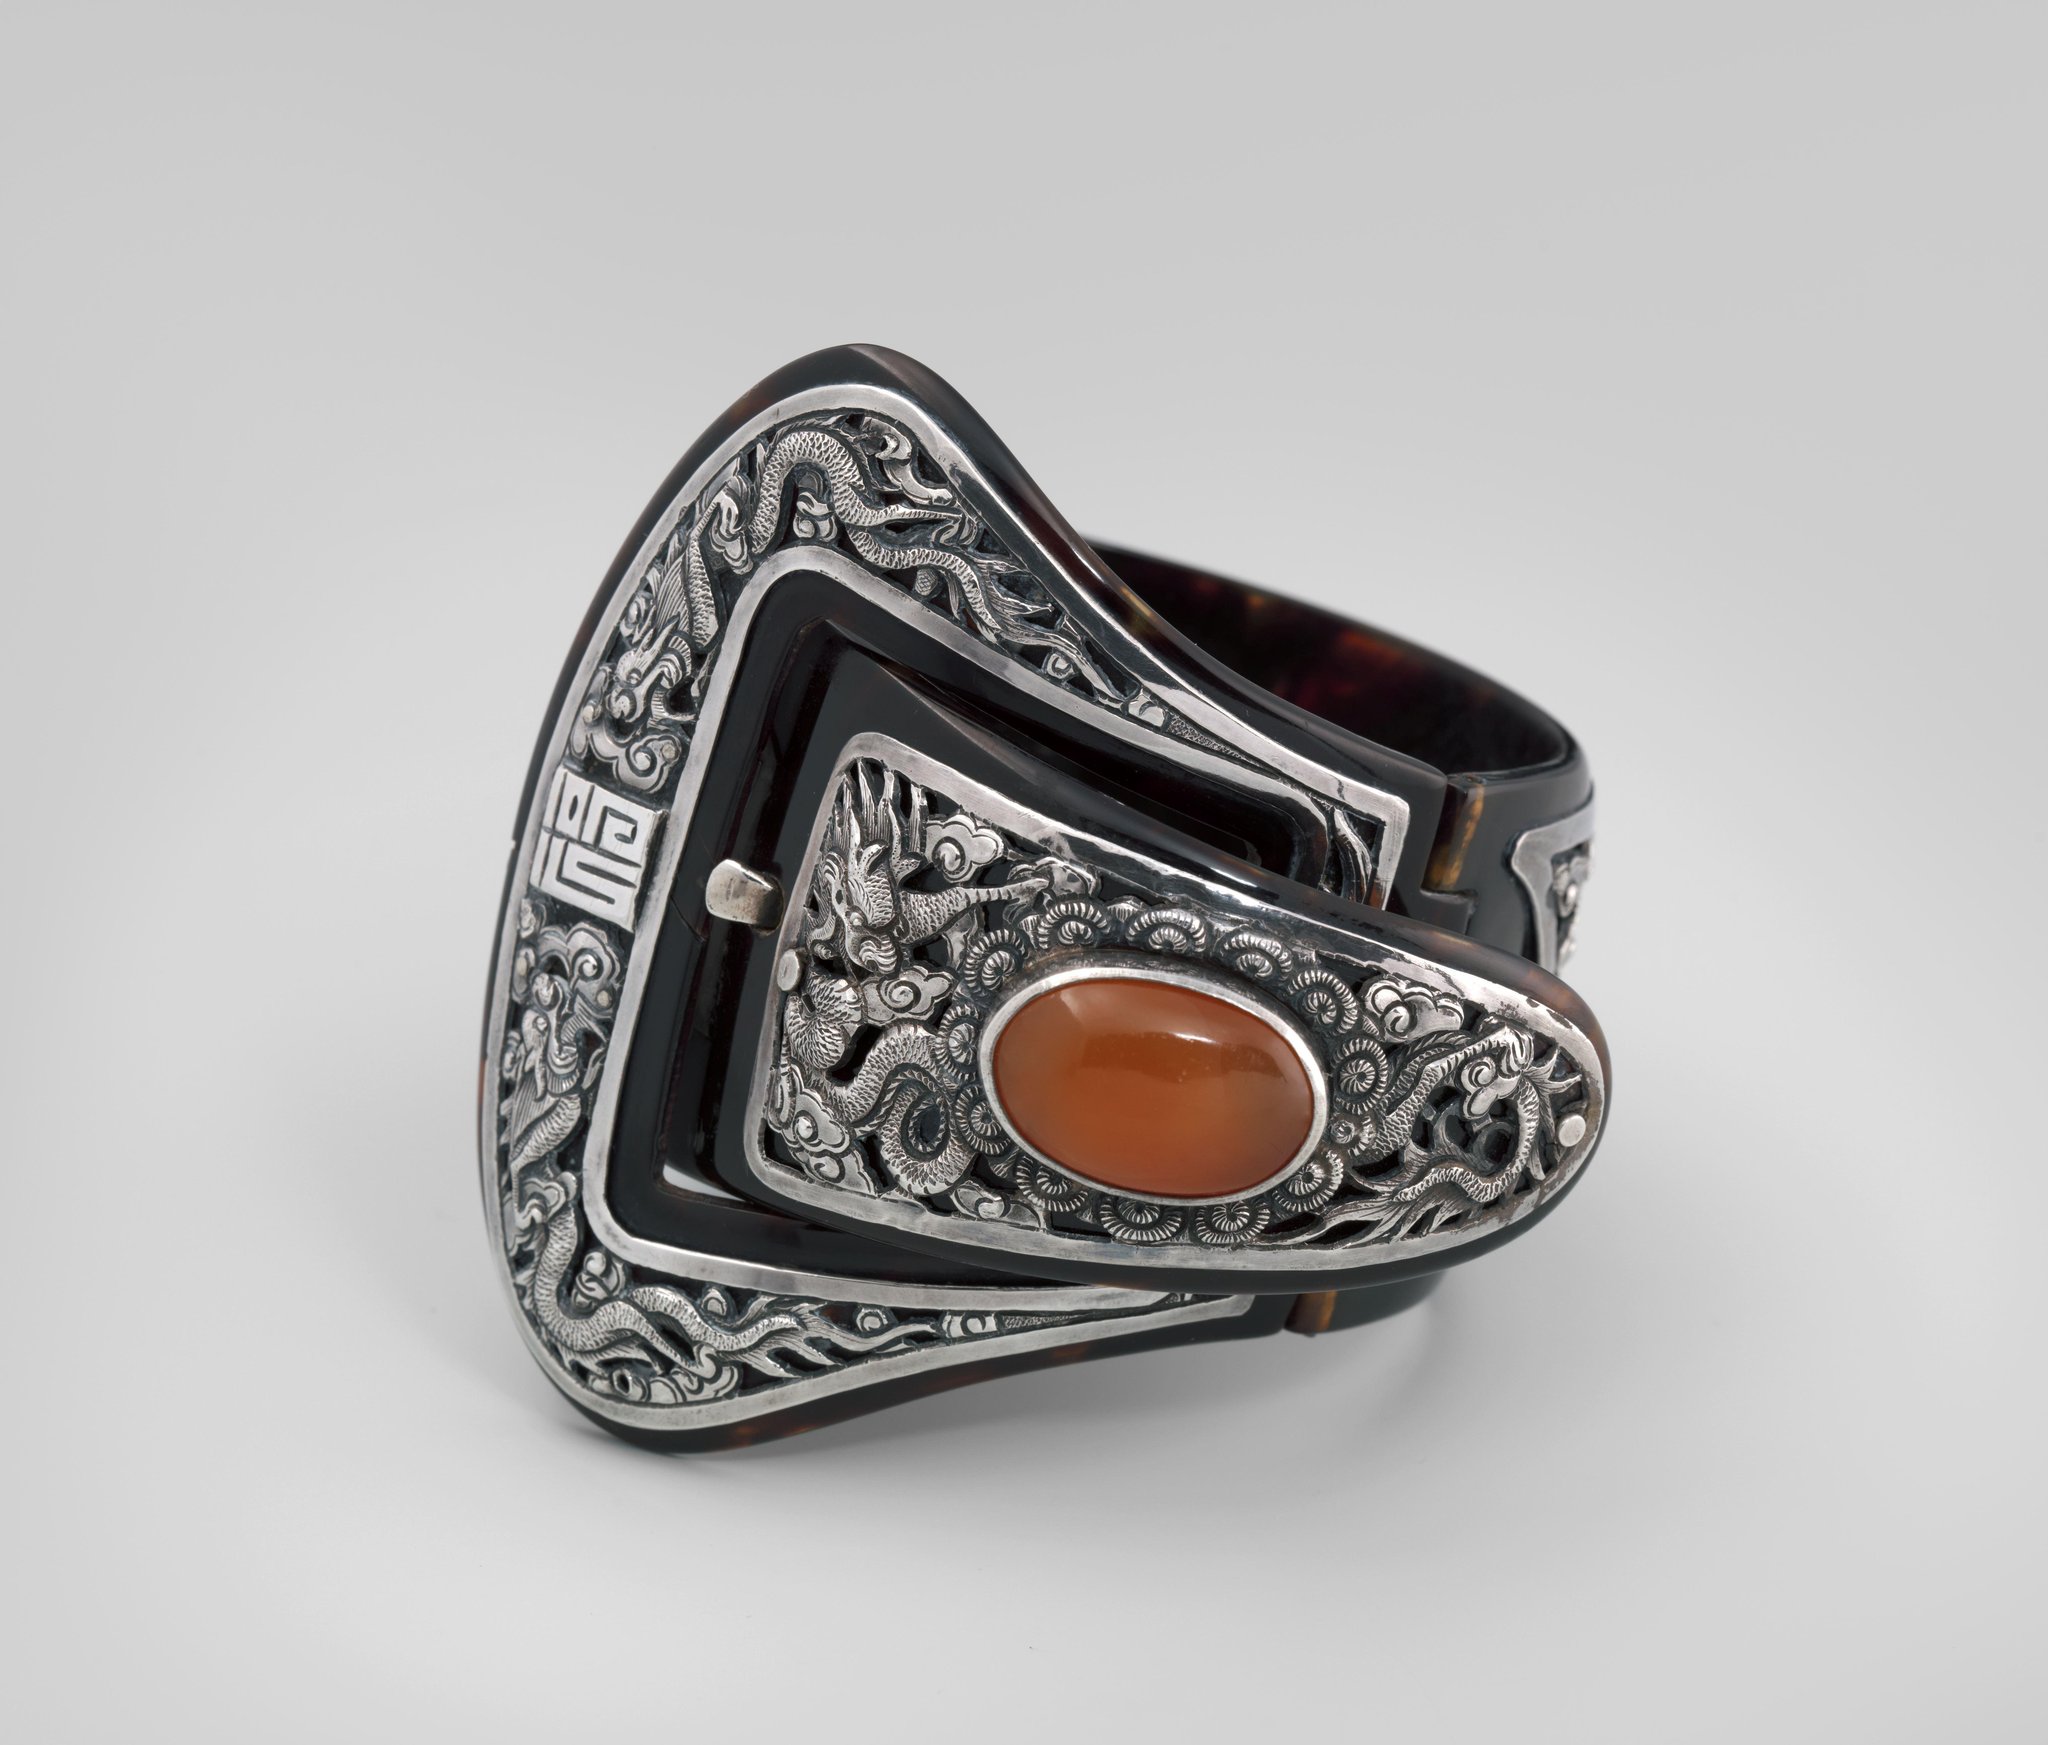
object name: bracelet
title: Armband van buffelhoorn, zilver en carneool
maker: Anonymous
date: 1940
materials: gemstone, silver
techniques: grinding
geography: europe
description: Armband in de vorm van een gesp van buffelhoorn, met zilver appliques en een ovaal cabochon geslepen carneool.